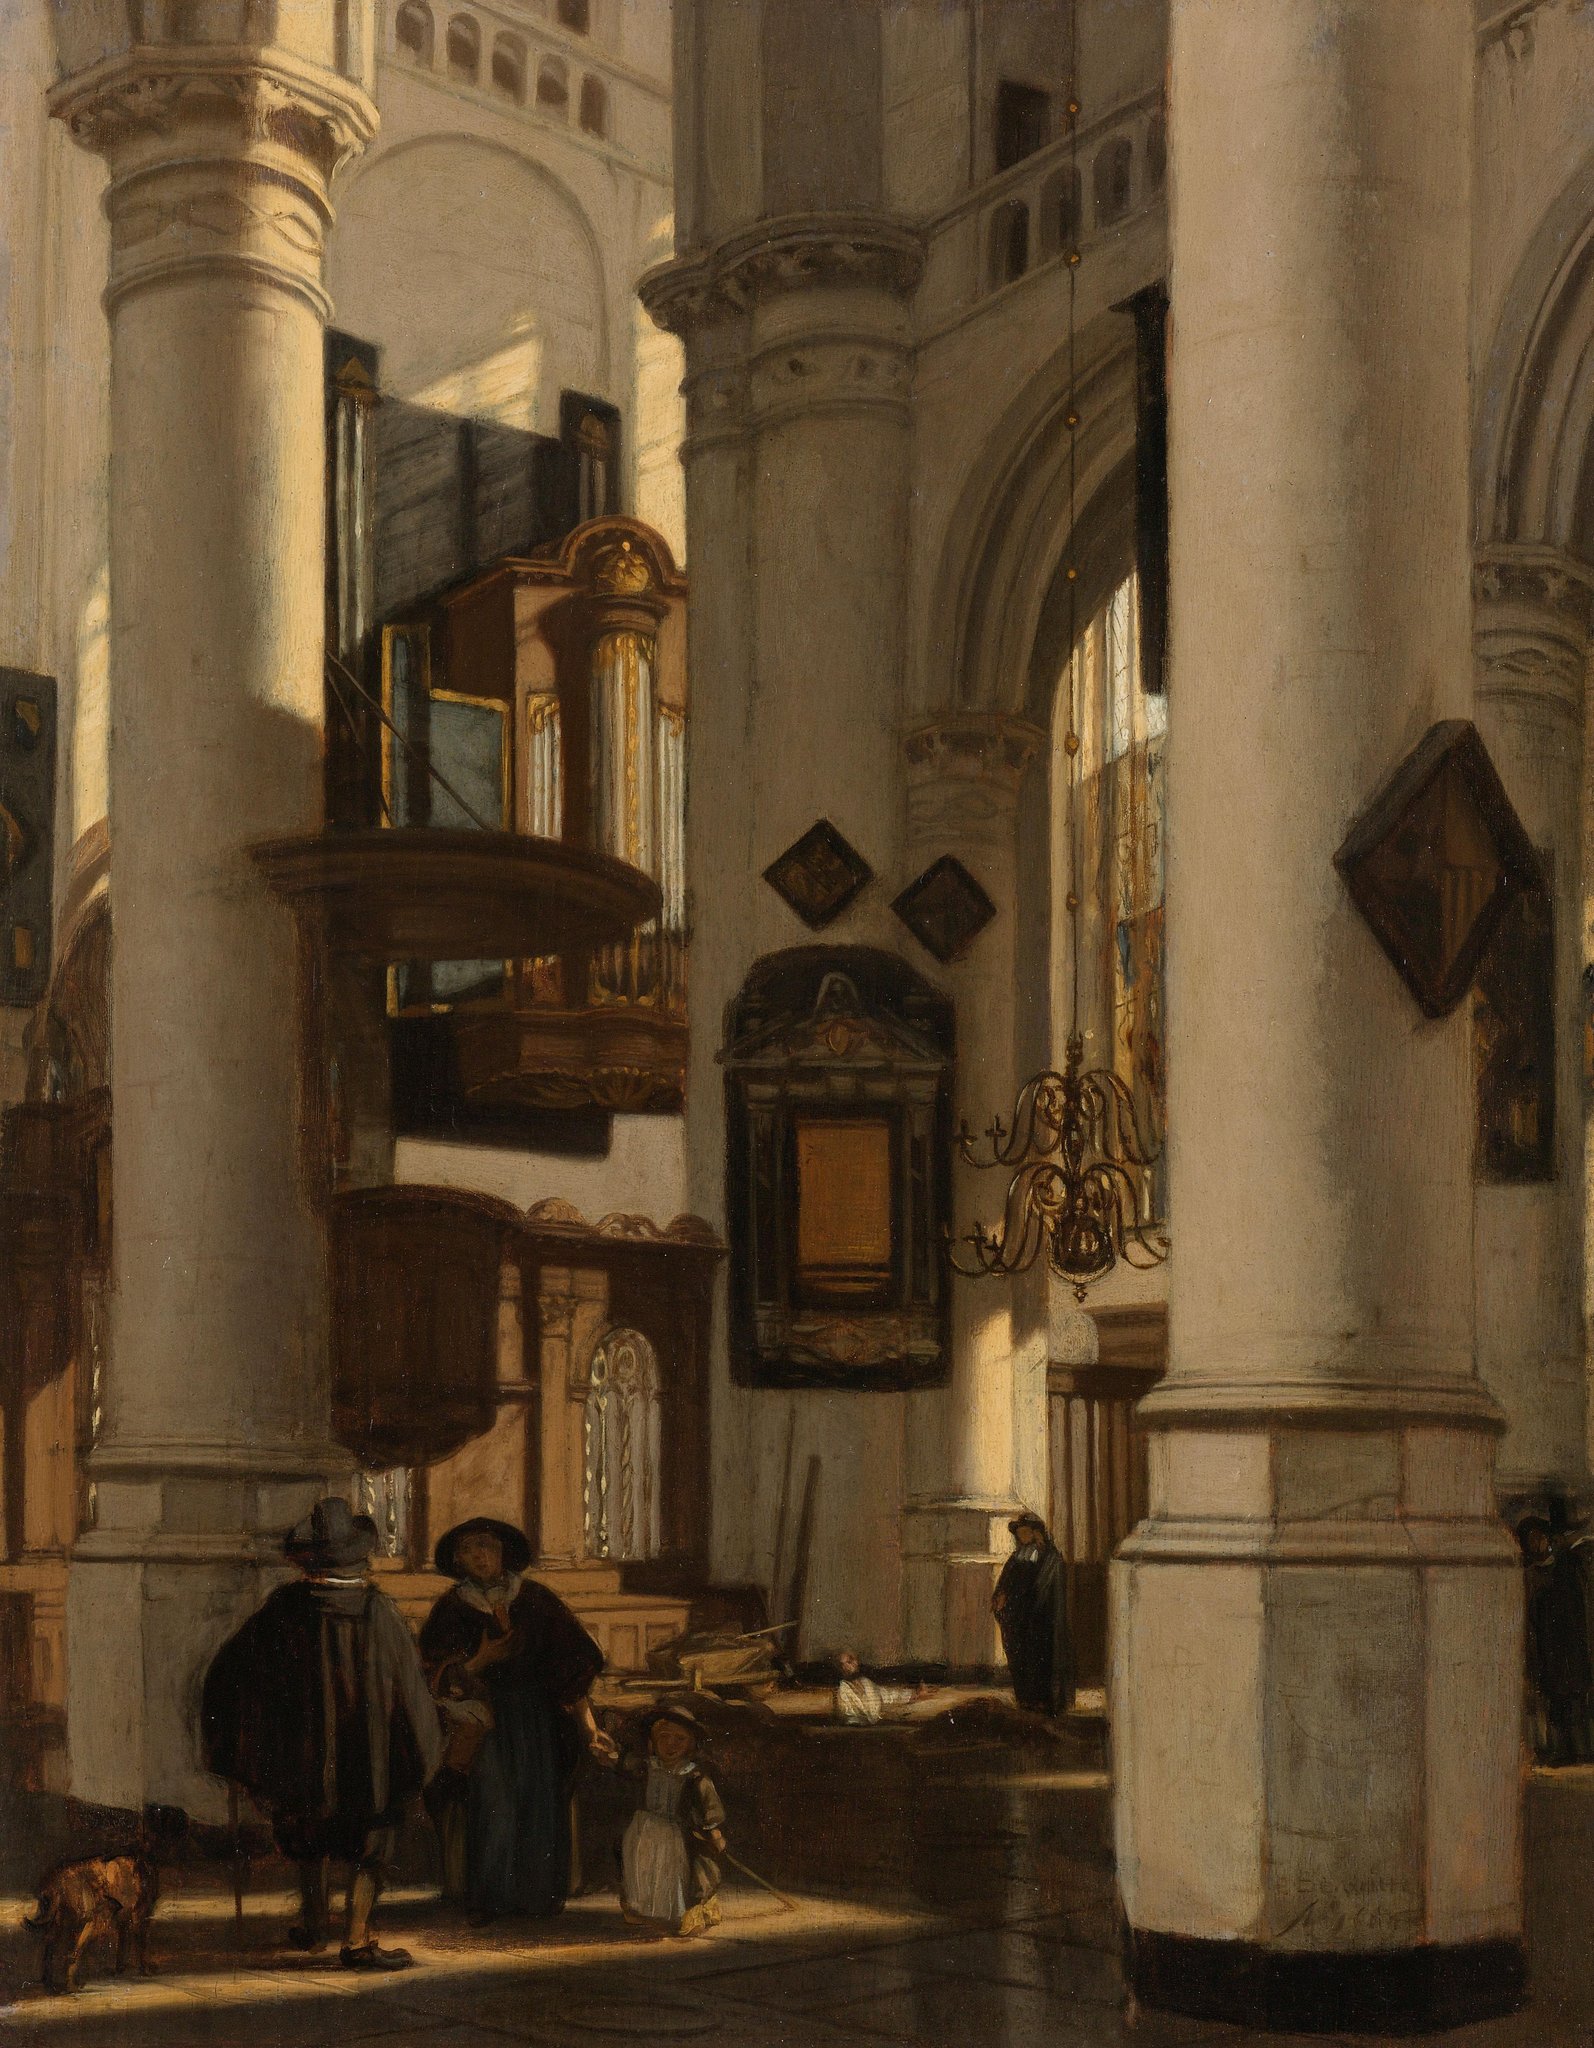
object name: painting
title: Interior of a Protestant, Gothic Church, with a Gravedigger in the Choir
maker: emanuel de witte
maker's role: painter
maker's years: 1617-1692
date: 1669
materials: oil, panel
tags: interior of church, grave digger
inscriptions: signature and date: ‘E. De Witte Aº 1669’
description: The depiction of church interiors was a separate speciality. De Witte was one of the last 17th-century artists to concentrate on these perspectival masterpieces. This painting offers an oblique ‘through-view’ into a church. The columns in the foreground lead the eye into the distance. In the background the light falls on a gravedigger; it was customary for eminent citizens to be buried in churches.